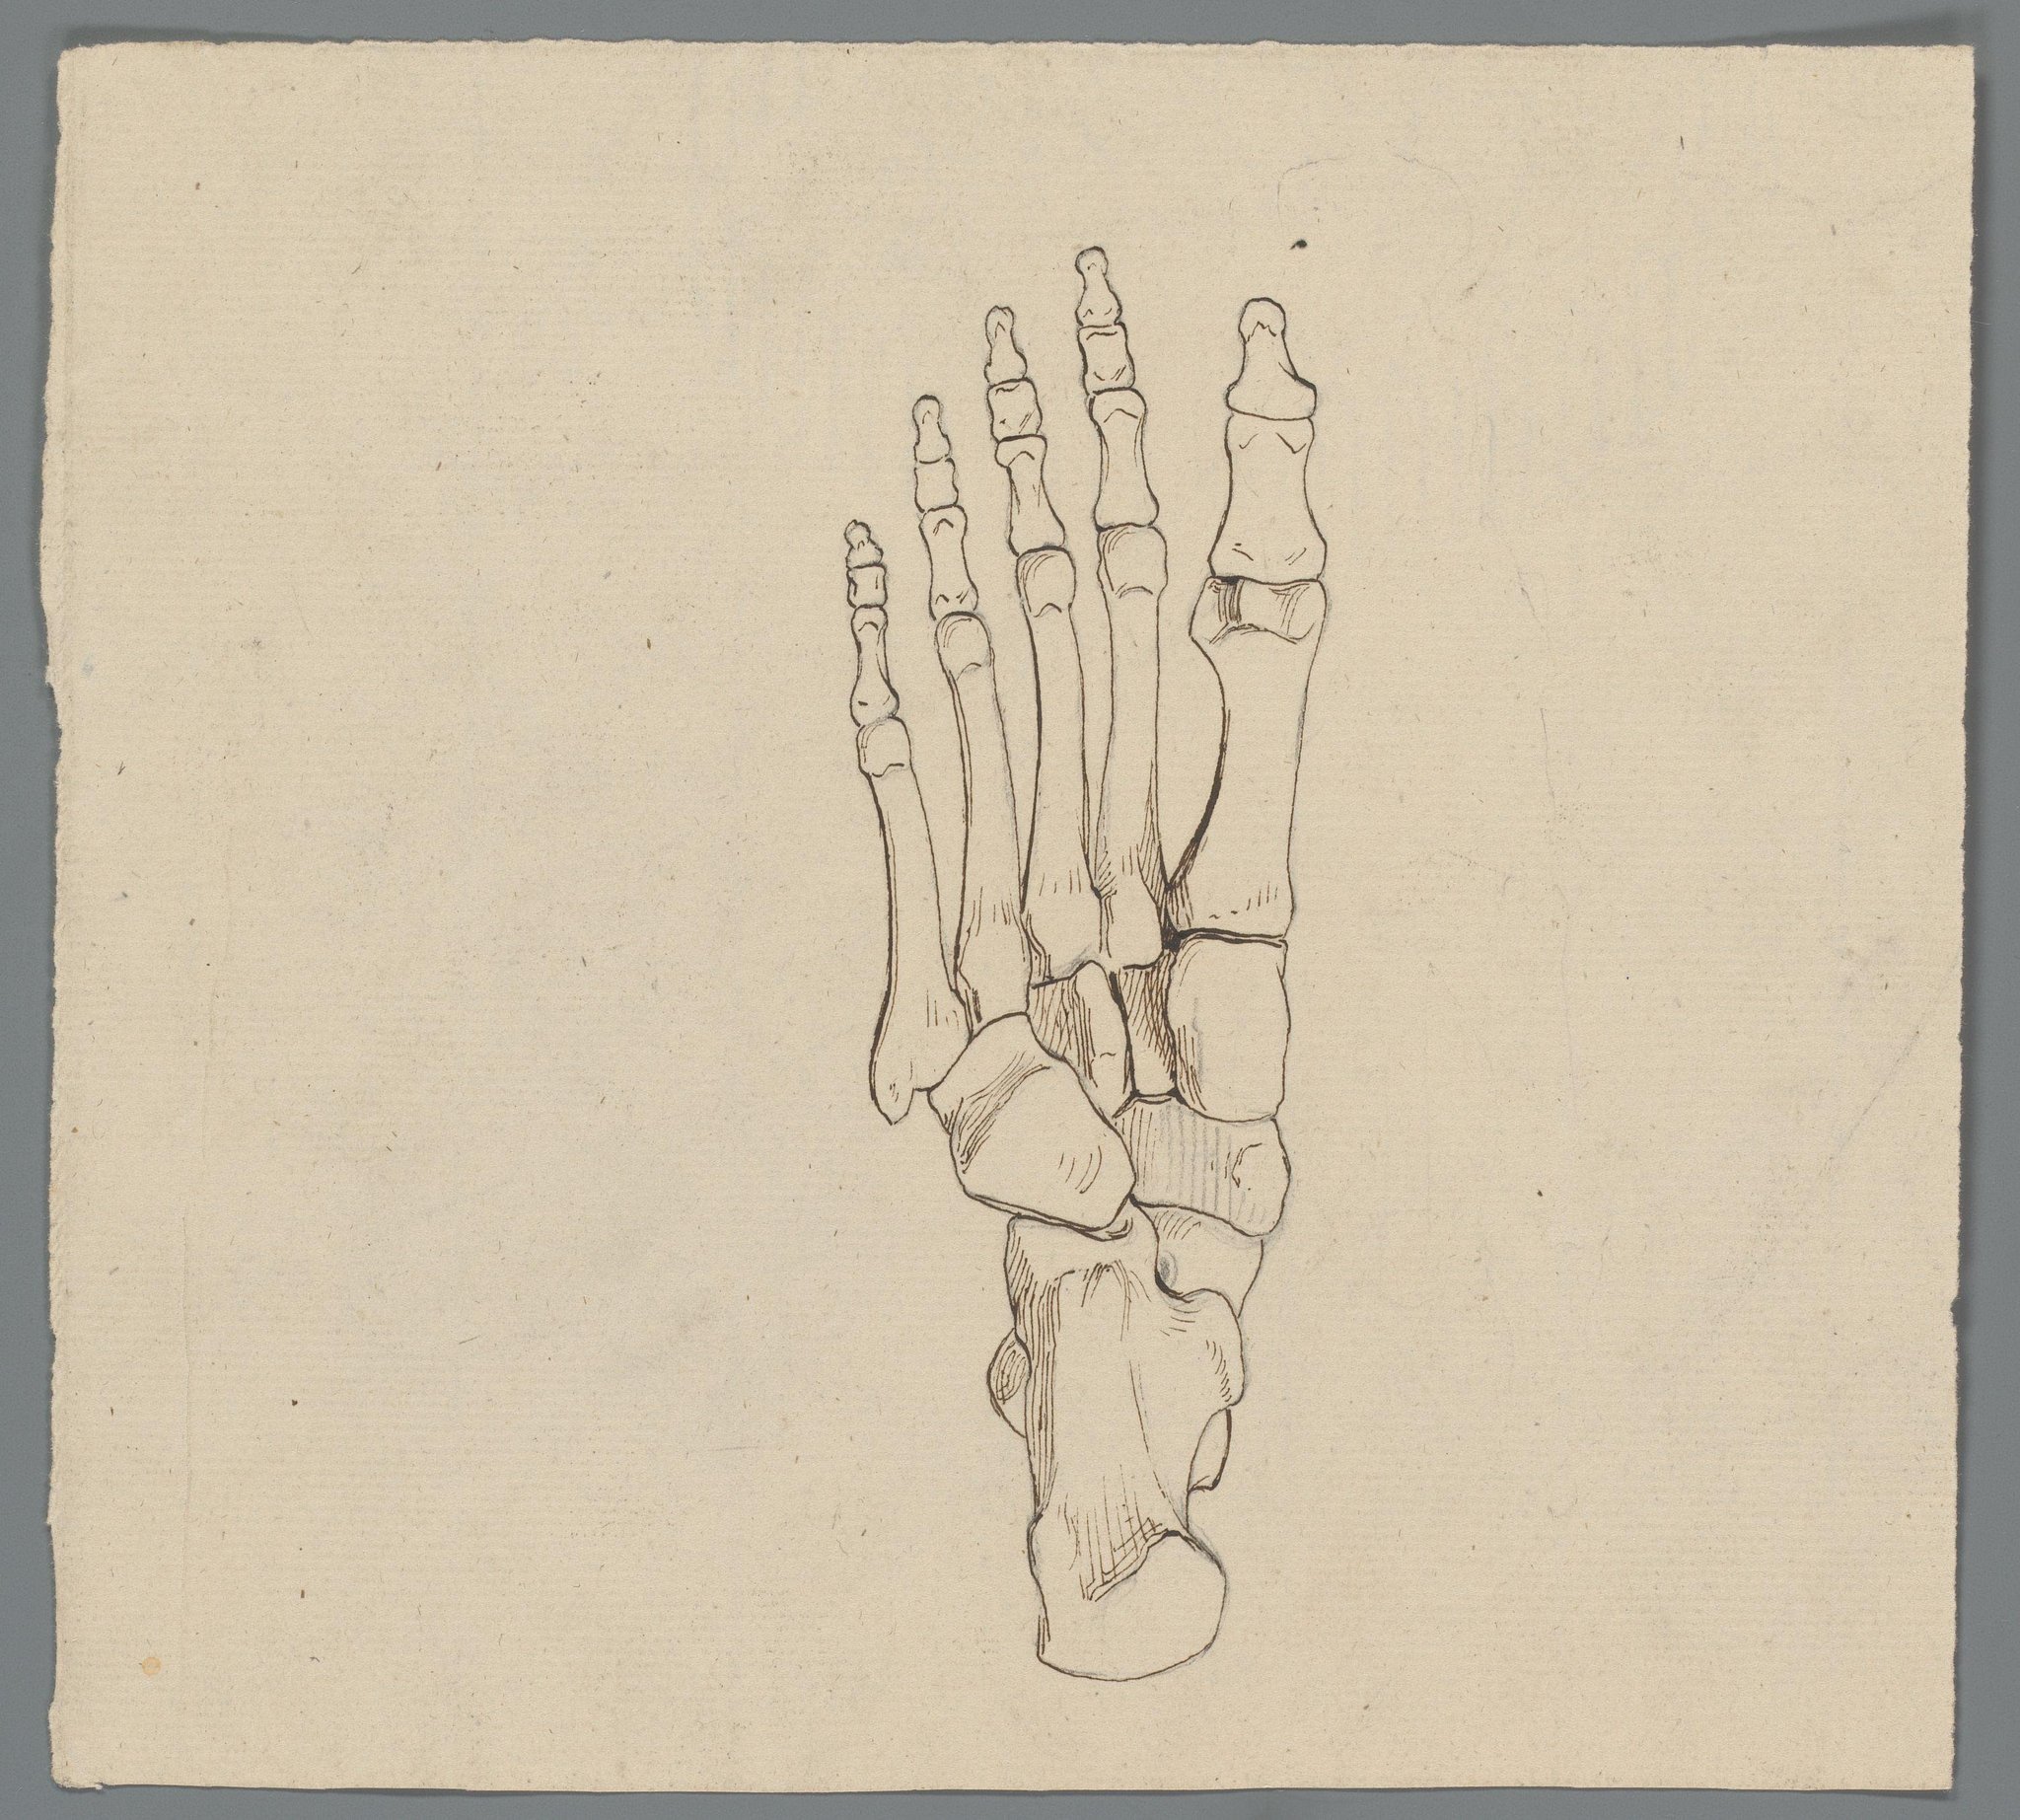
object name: drawing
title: Skelet van een voet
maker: jacobus everhardus josephus van den berg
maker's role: draughtsman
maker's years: 1802-1861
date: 1812-1861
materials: ink, paper, pencil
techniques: pen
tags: tarsus and metatarsus, parts of the foot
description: Tekening in een papieren omslagje met de tekst 'Weir's Sketch Book of Animals, No. 170 - 4 parts'.